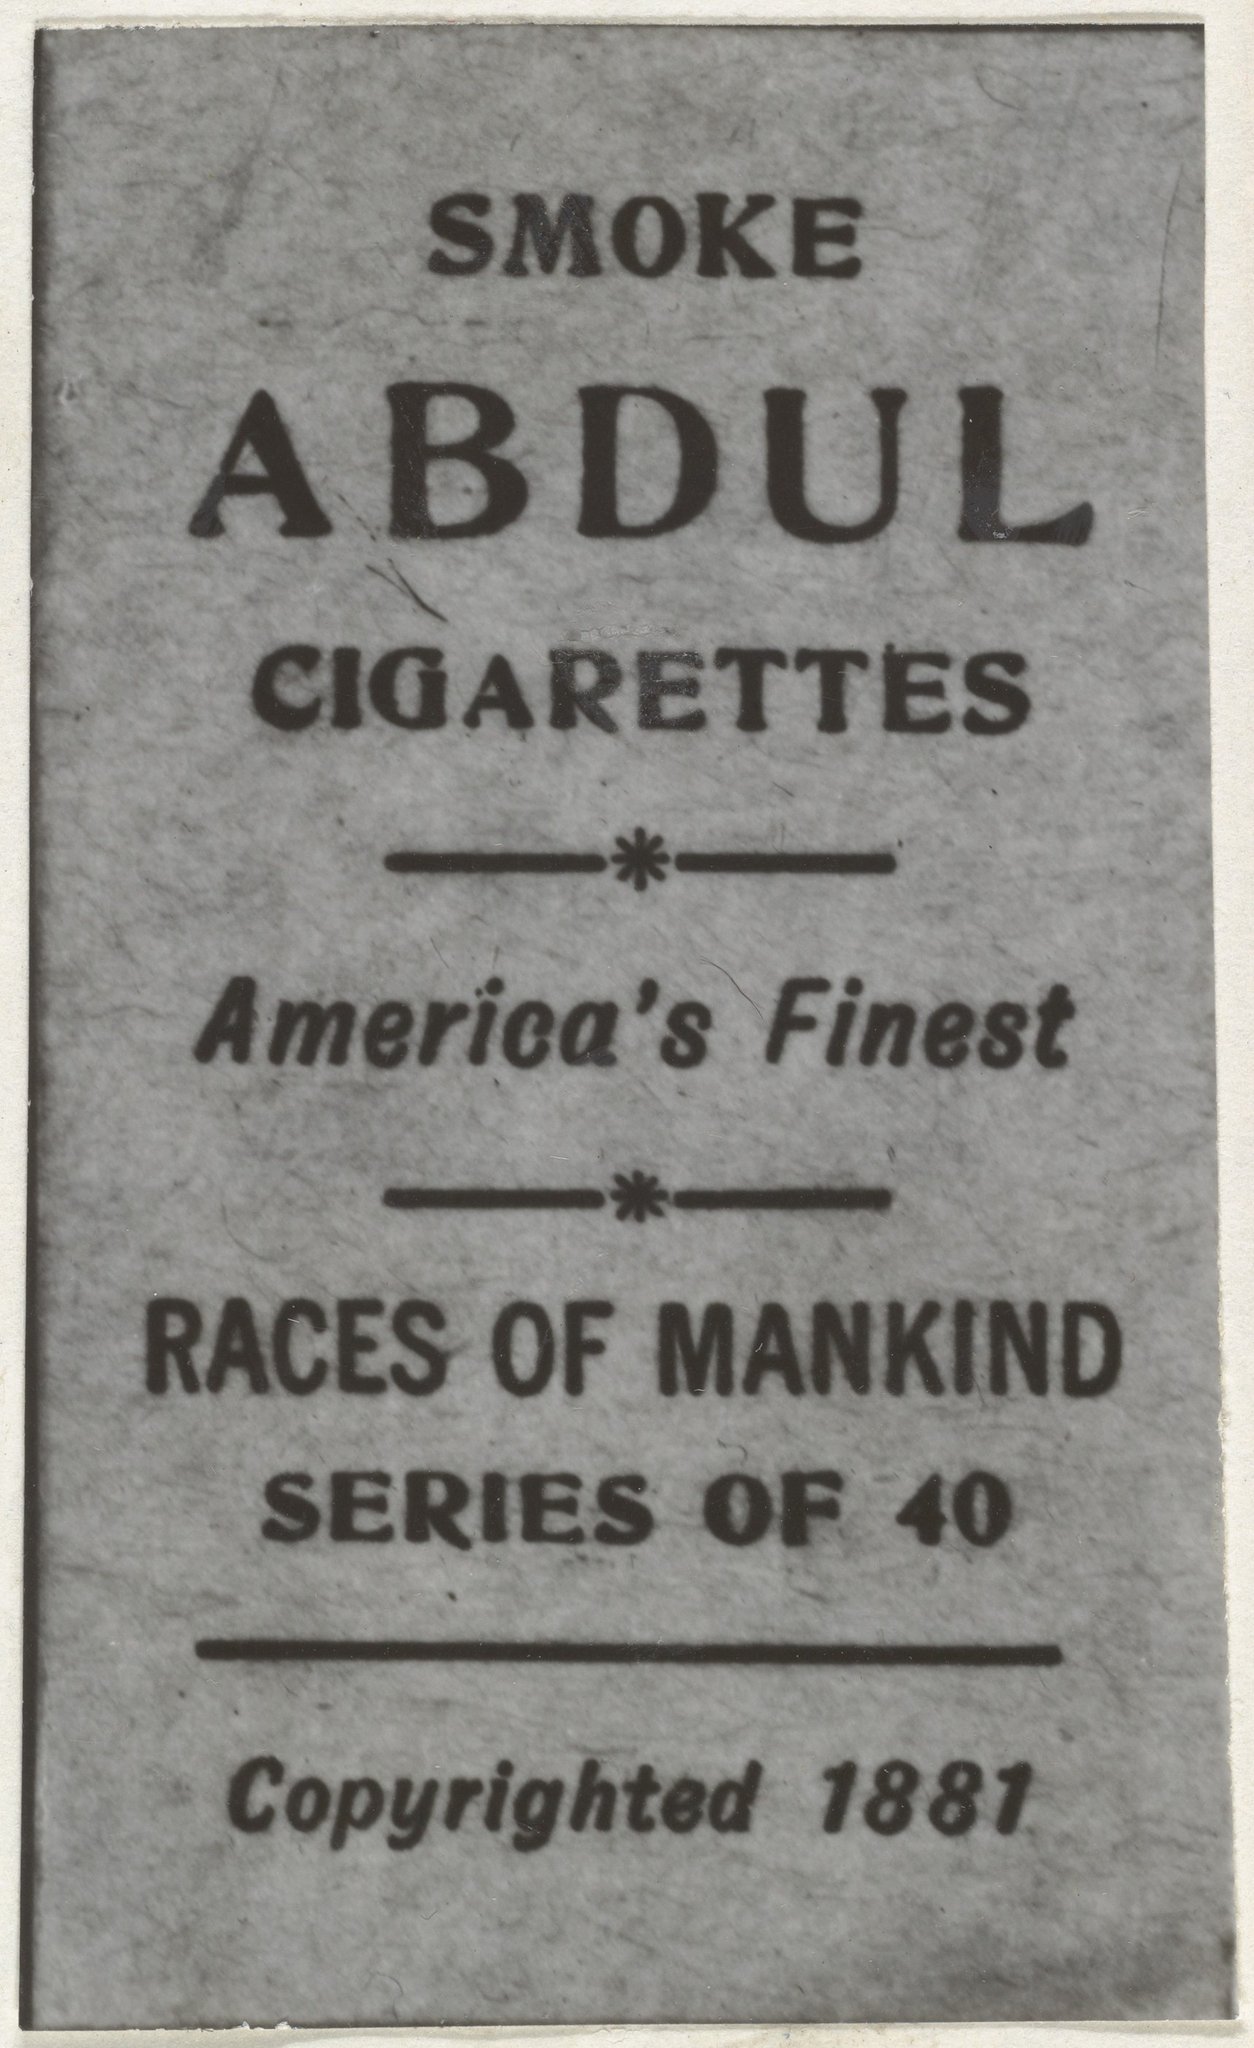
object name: print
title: Facsimile of card verso from the Races of Mankind series (T181) issued by Abdul Cigarettes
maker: abdul cigarettes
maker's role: publisher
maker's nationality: american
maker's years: 1881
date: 1881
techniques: color lithograph